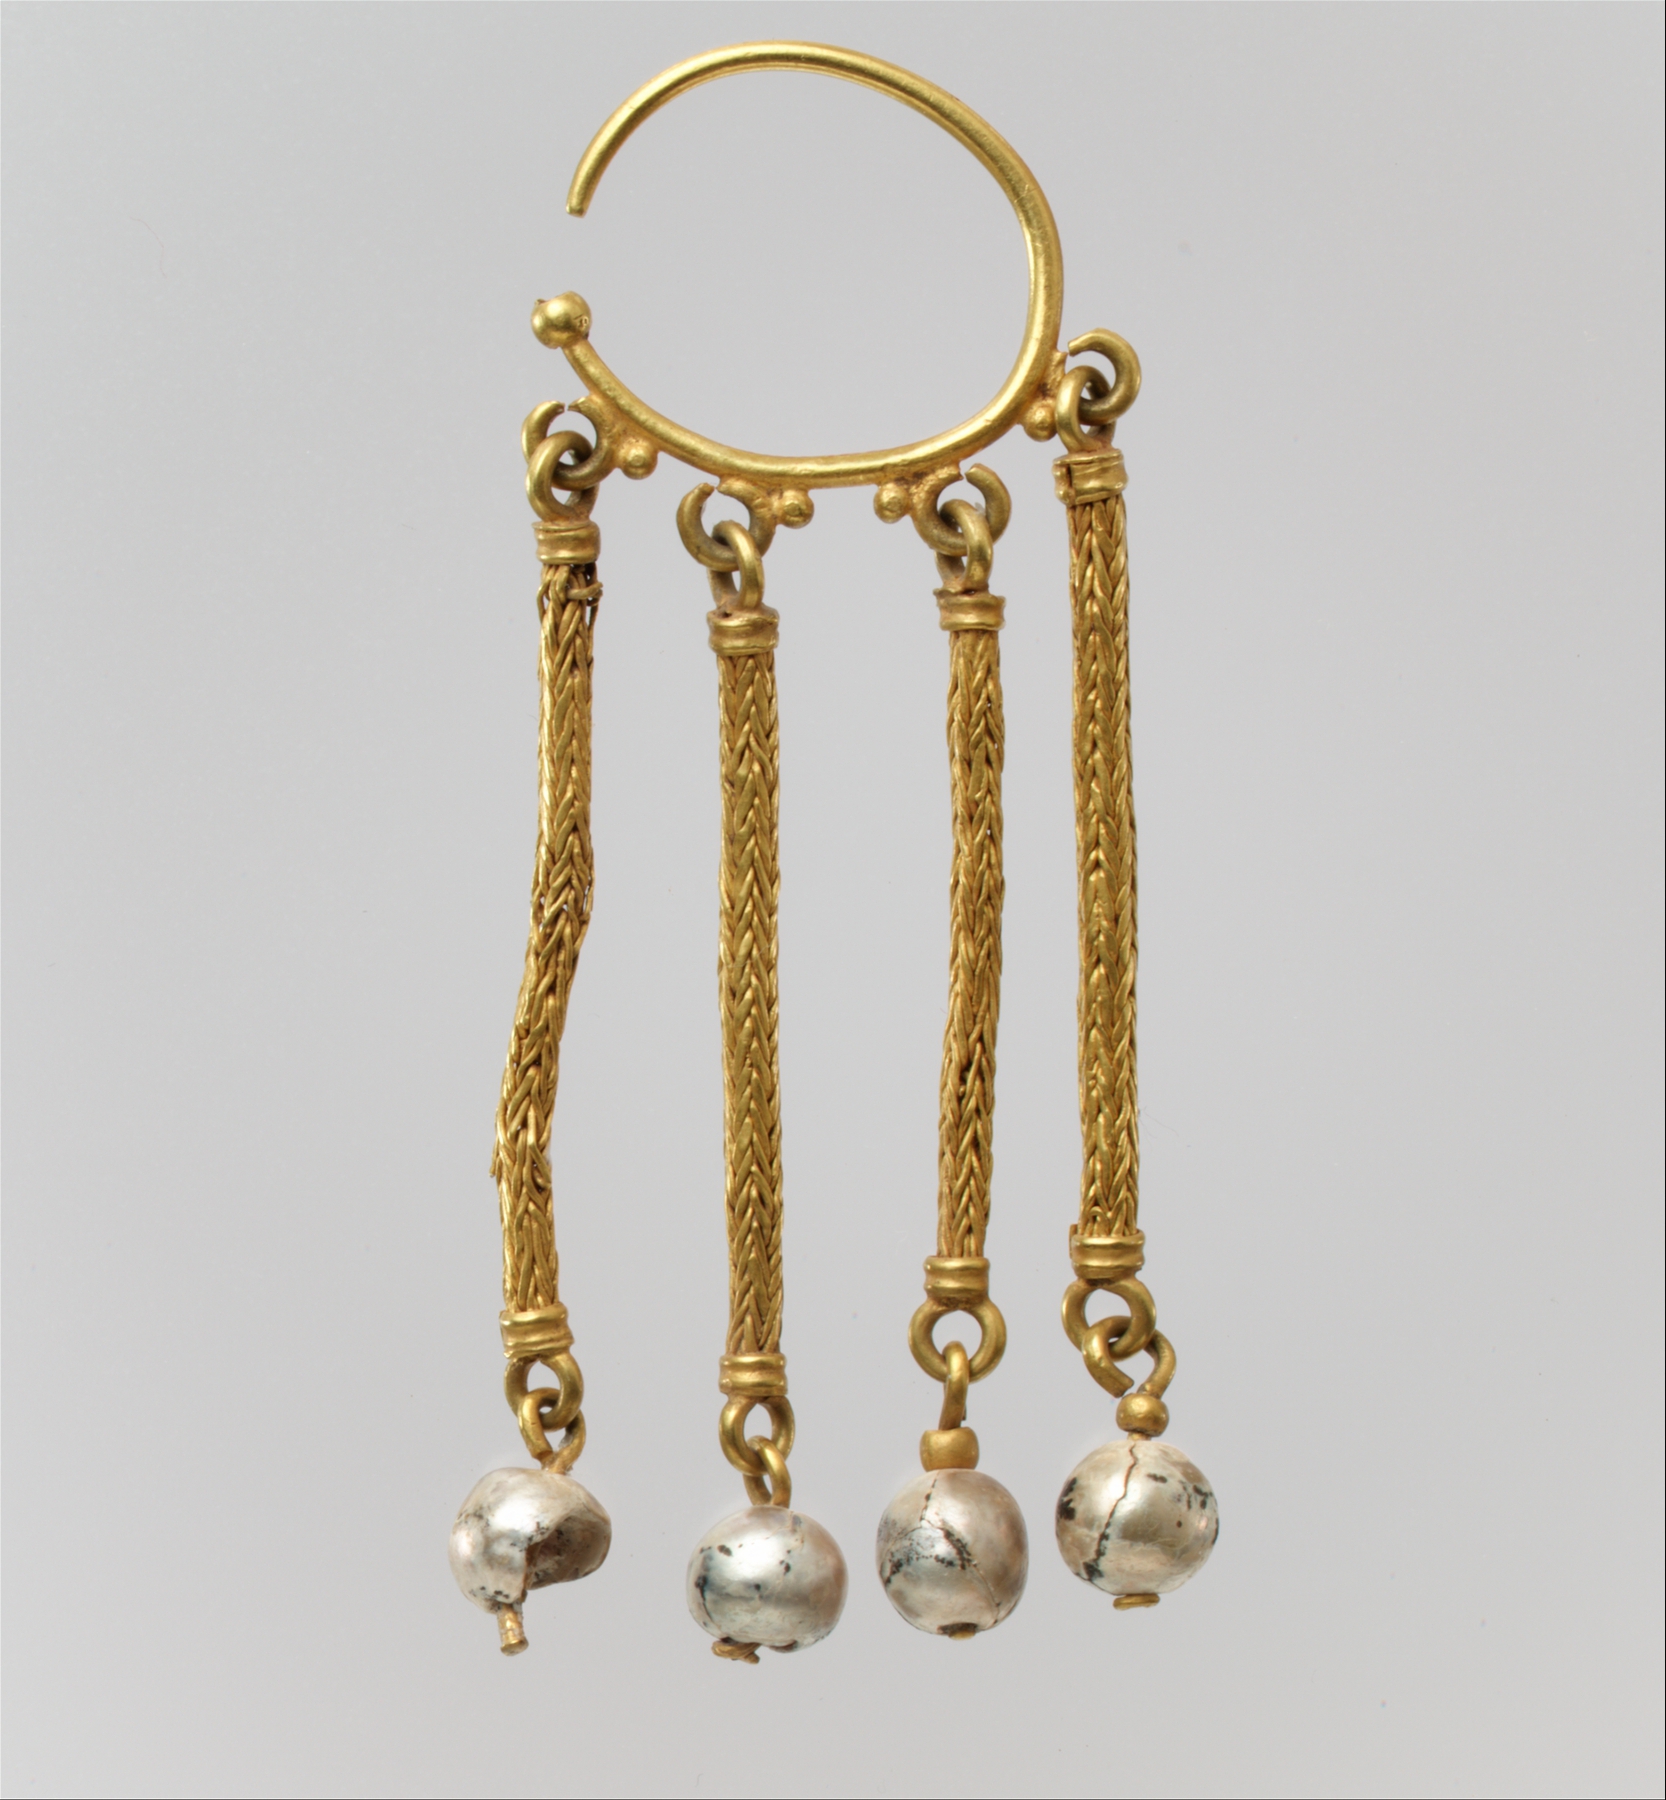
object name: earring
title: Earring (one of a pair)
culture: byzantine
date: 501-700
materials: gold, pearl